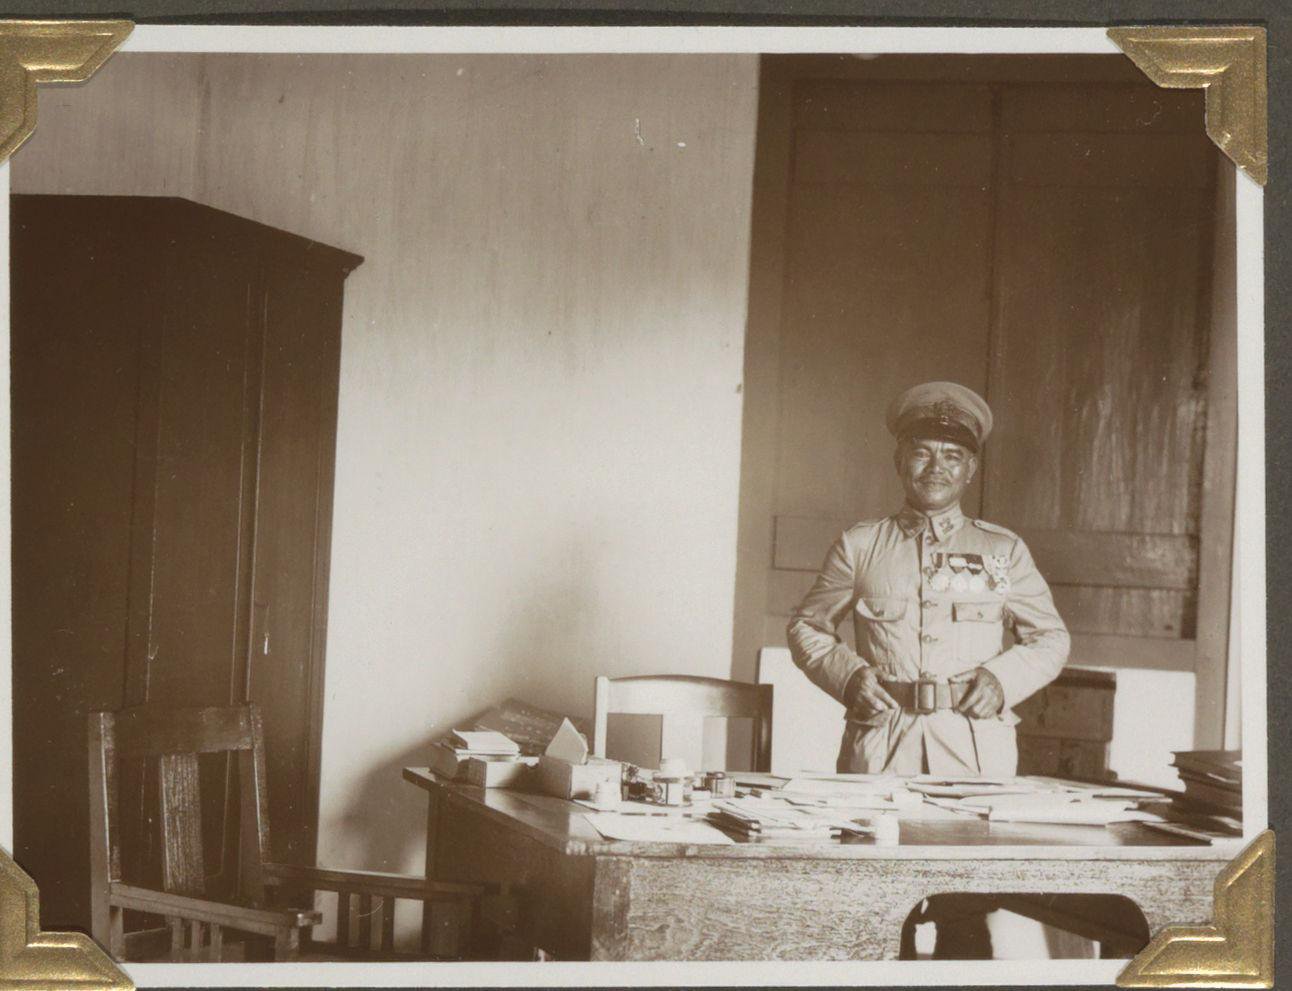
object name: photograph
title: Magazijnmeester van de politie te Lampong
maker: Anonymous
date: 1932-1933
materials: photographic support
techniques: gelatin silver print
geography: lampung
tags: large-scale structure for storage, e.g.: warehouse, depot, silo, police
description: Onderdeel van Herinneringsalbum voor F.J. Junius, vertrekkend resident van Lampong (Zuid-Sumatra).